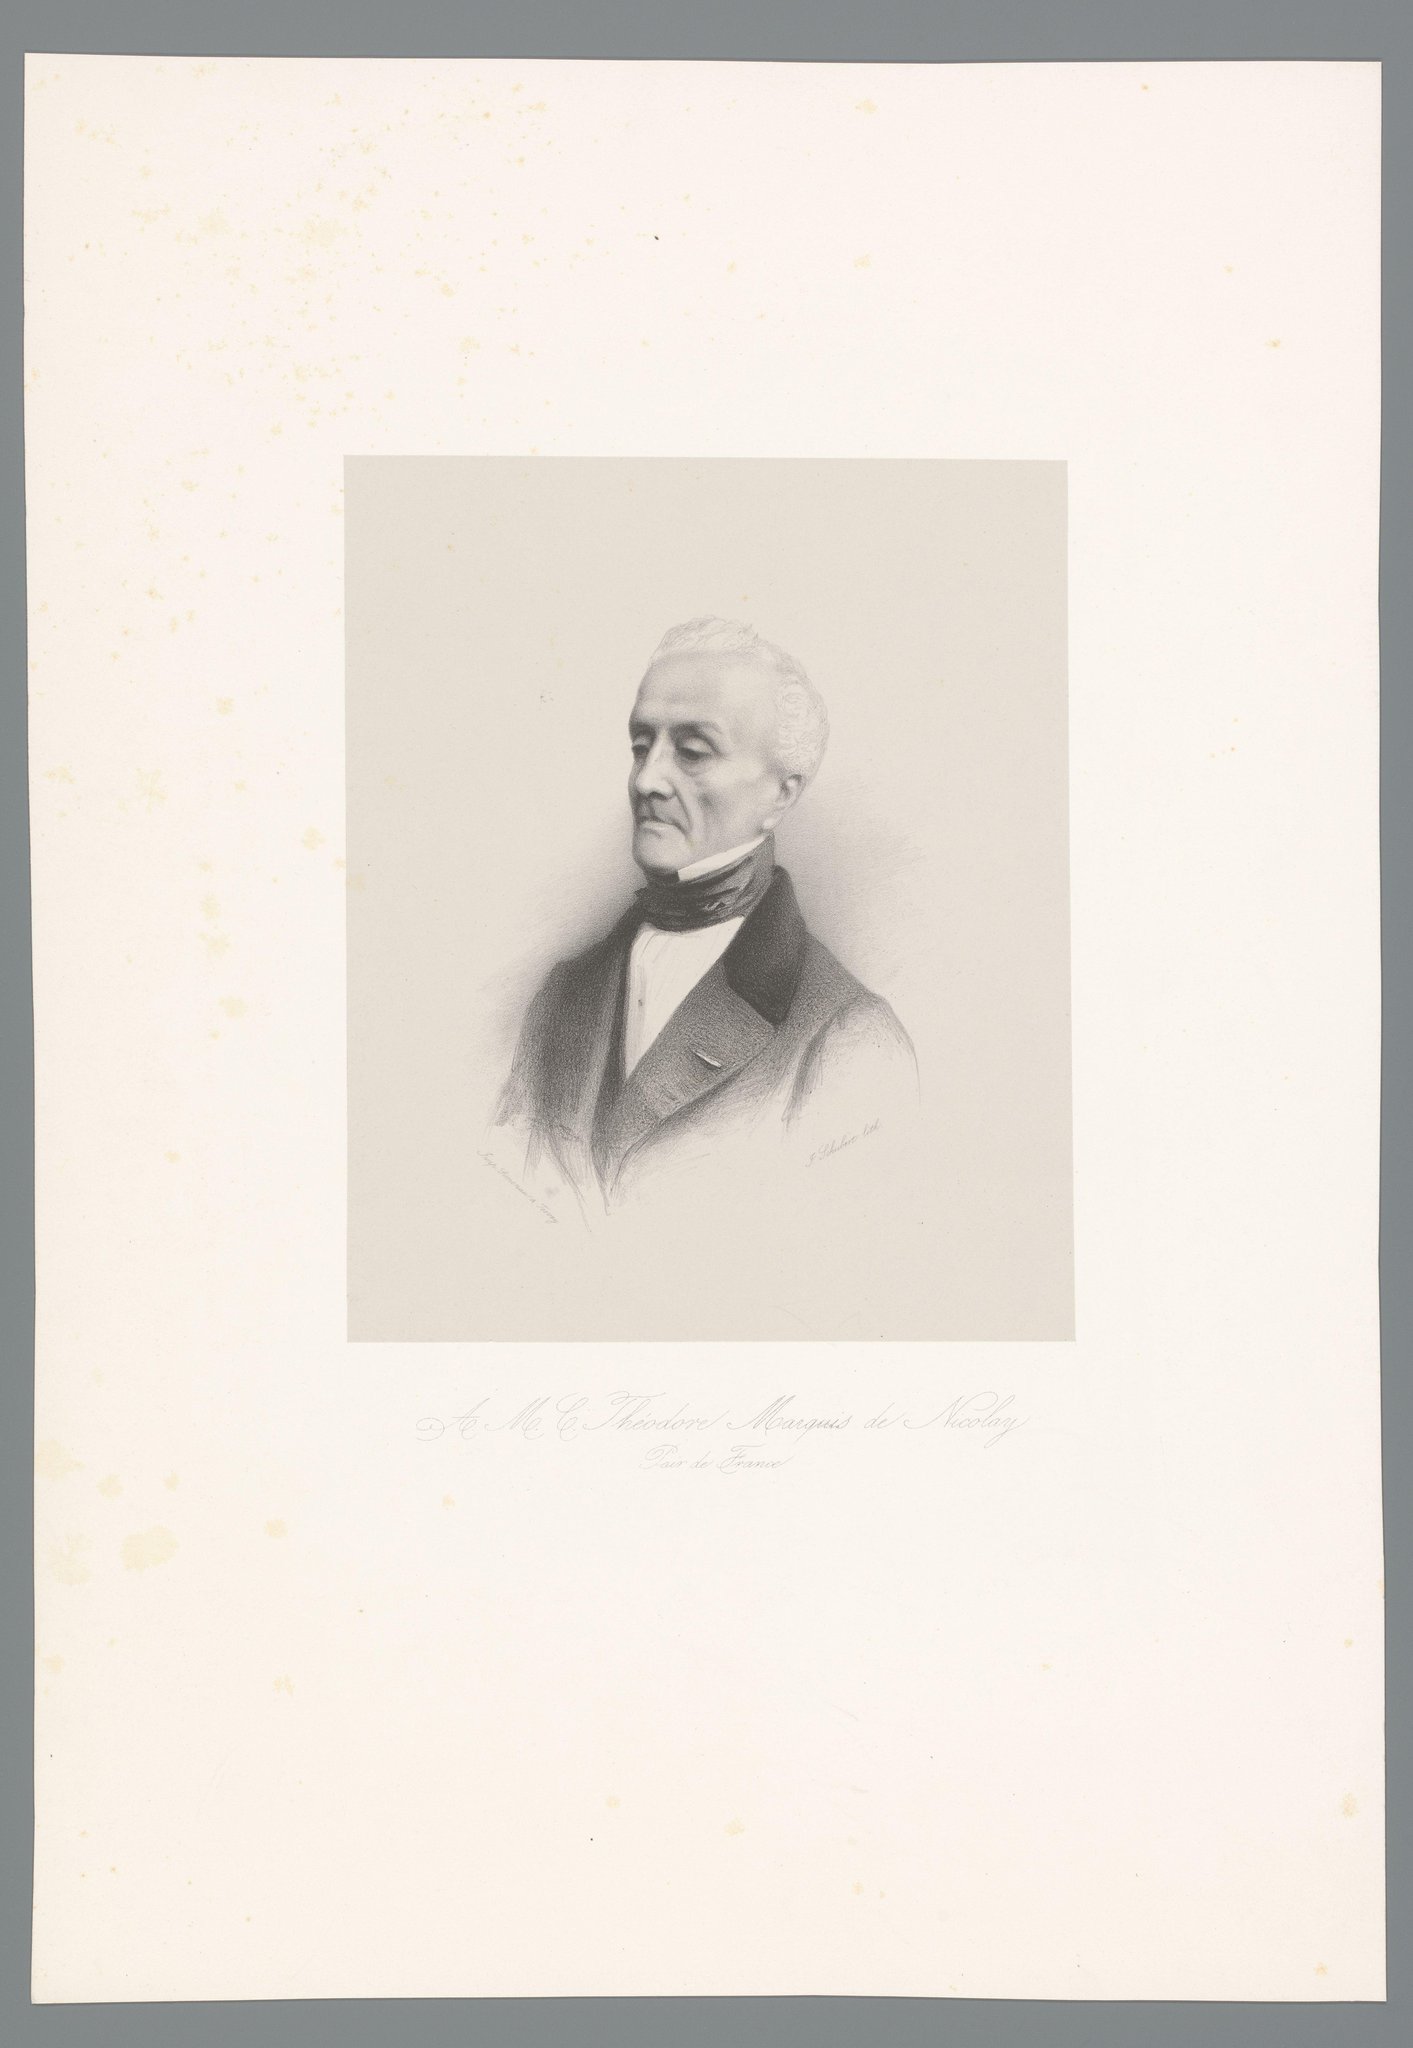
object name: print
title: Portret van Aymard-Charles-Marie-Théodore markies de Nicolaÿ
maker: joseph schubert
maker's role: print maker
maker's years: 1816-1885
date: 1847-1885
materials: paper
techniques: lithograph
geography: brussels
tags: paris, politician, historical persons, nobility and patriciate; chivalry, knighthood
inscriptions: collector's mark: Lugt 2228